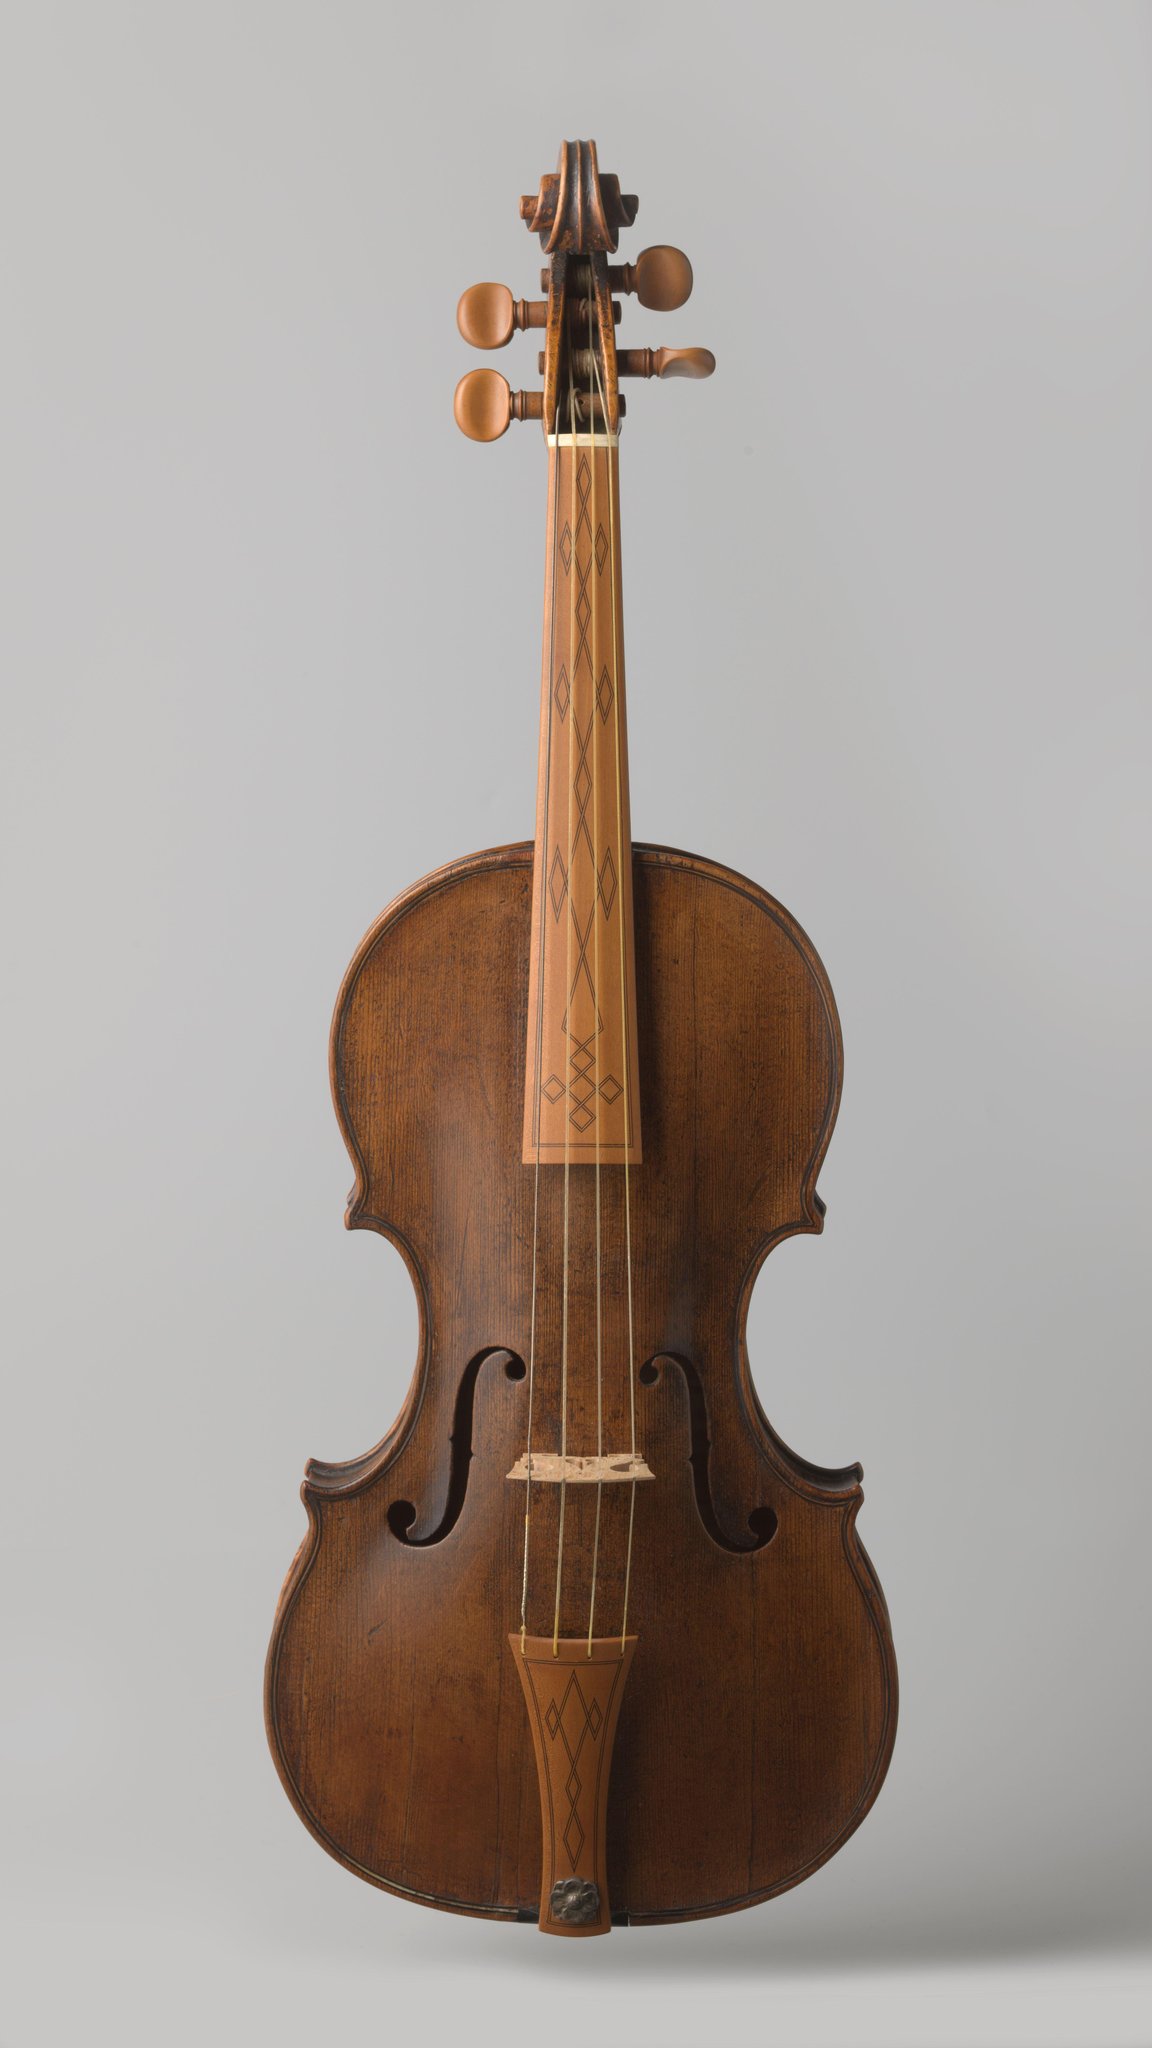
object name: musical instrument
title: Violin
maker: hendrik jacobs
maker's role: musical instrument maker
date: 1692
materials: wood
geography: amsterdam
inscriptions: date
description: Viool met dubbele zwarte randen ingelegd, etiket: HENDRIK JACOBS ME/ FECIT IN AMSTERDAM 1692.